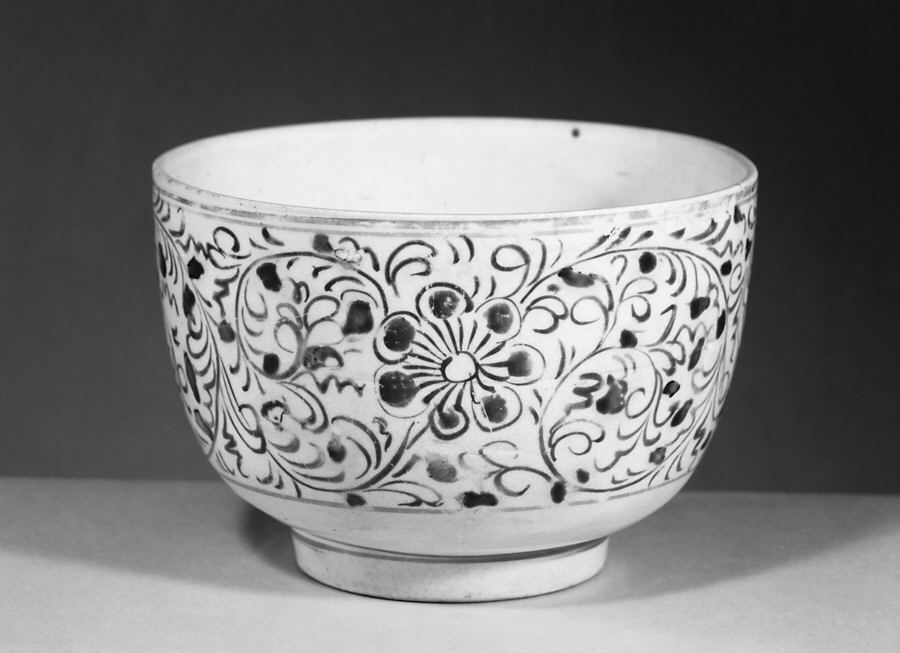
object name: bowl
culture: japanese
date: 1660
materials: enamel, porcelain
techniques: overglaze